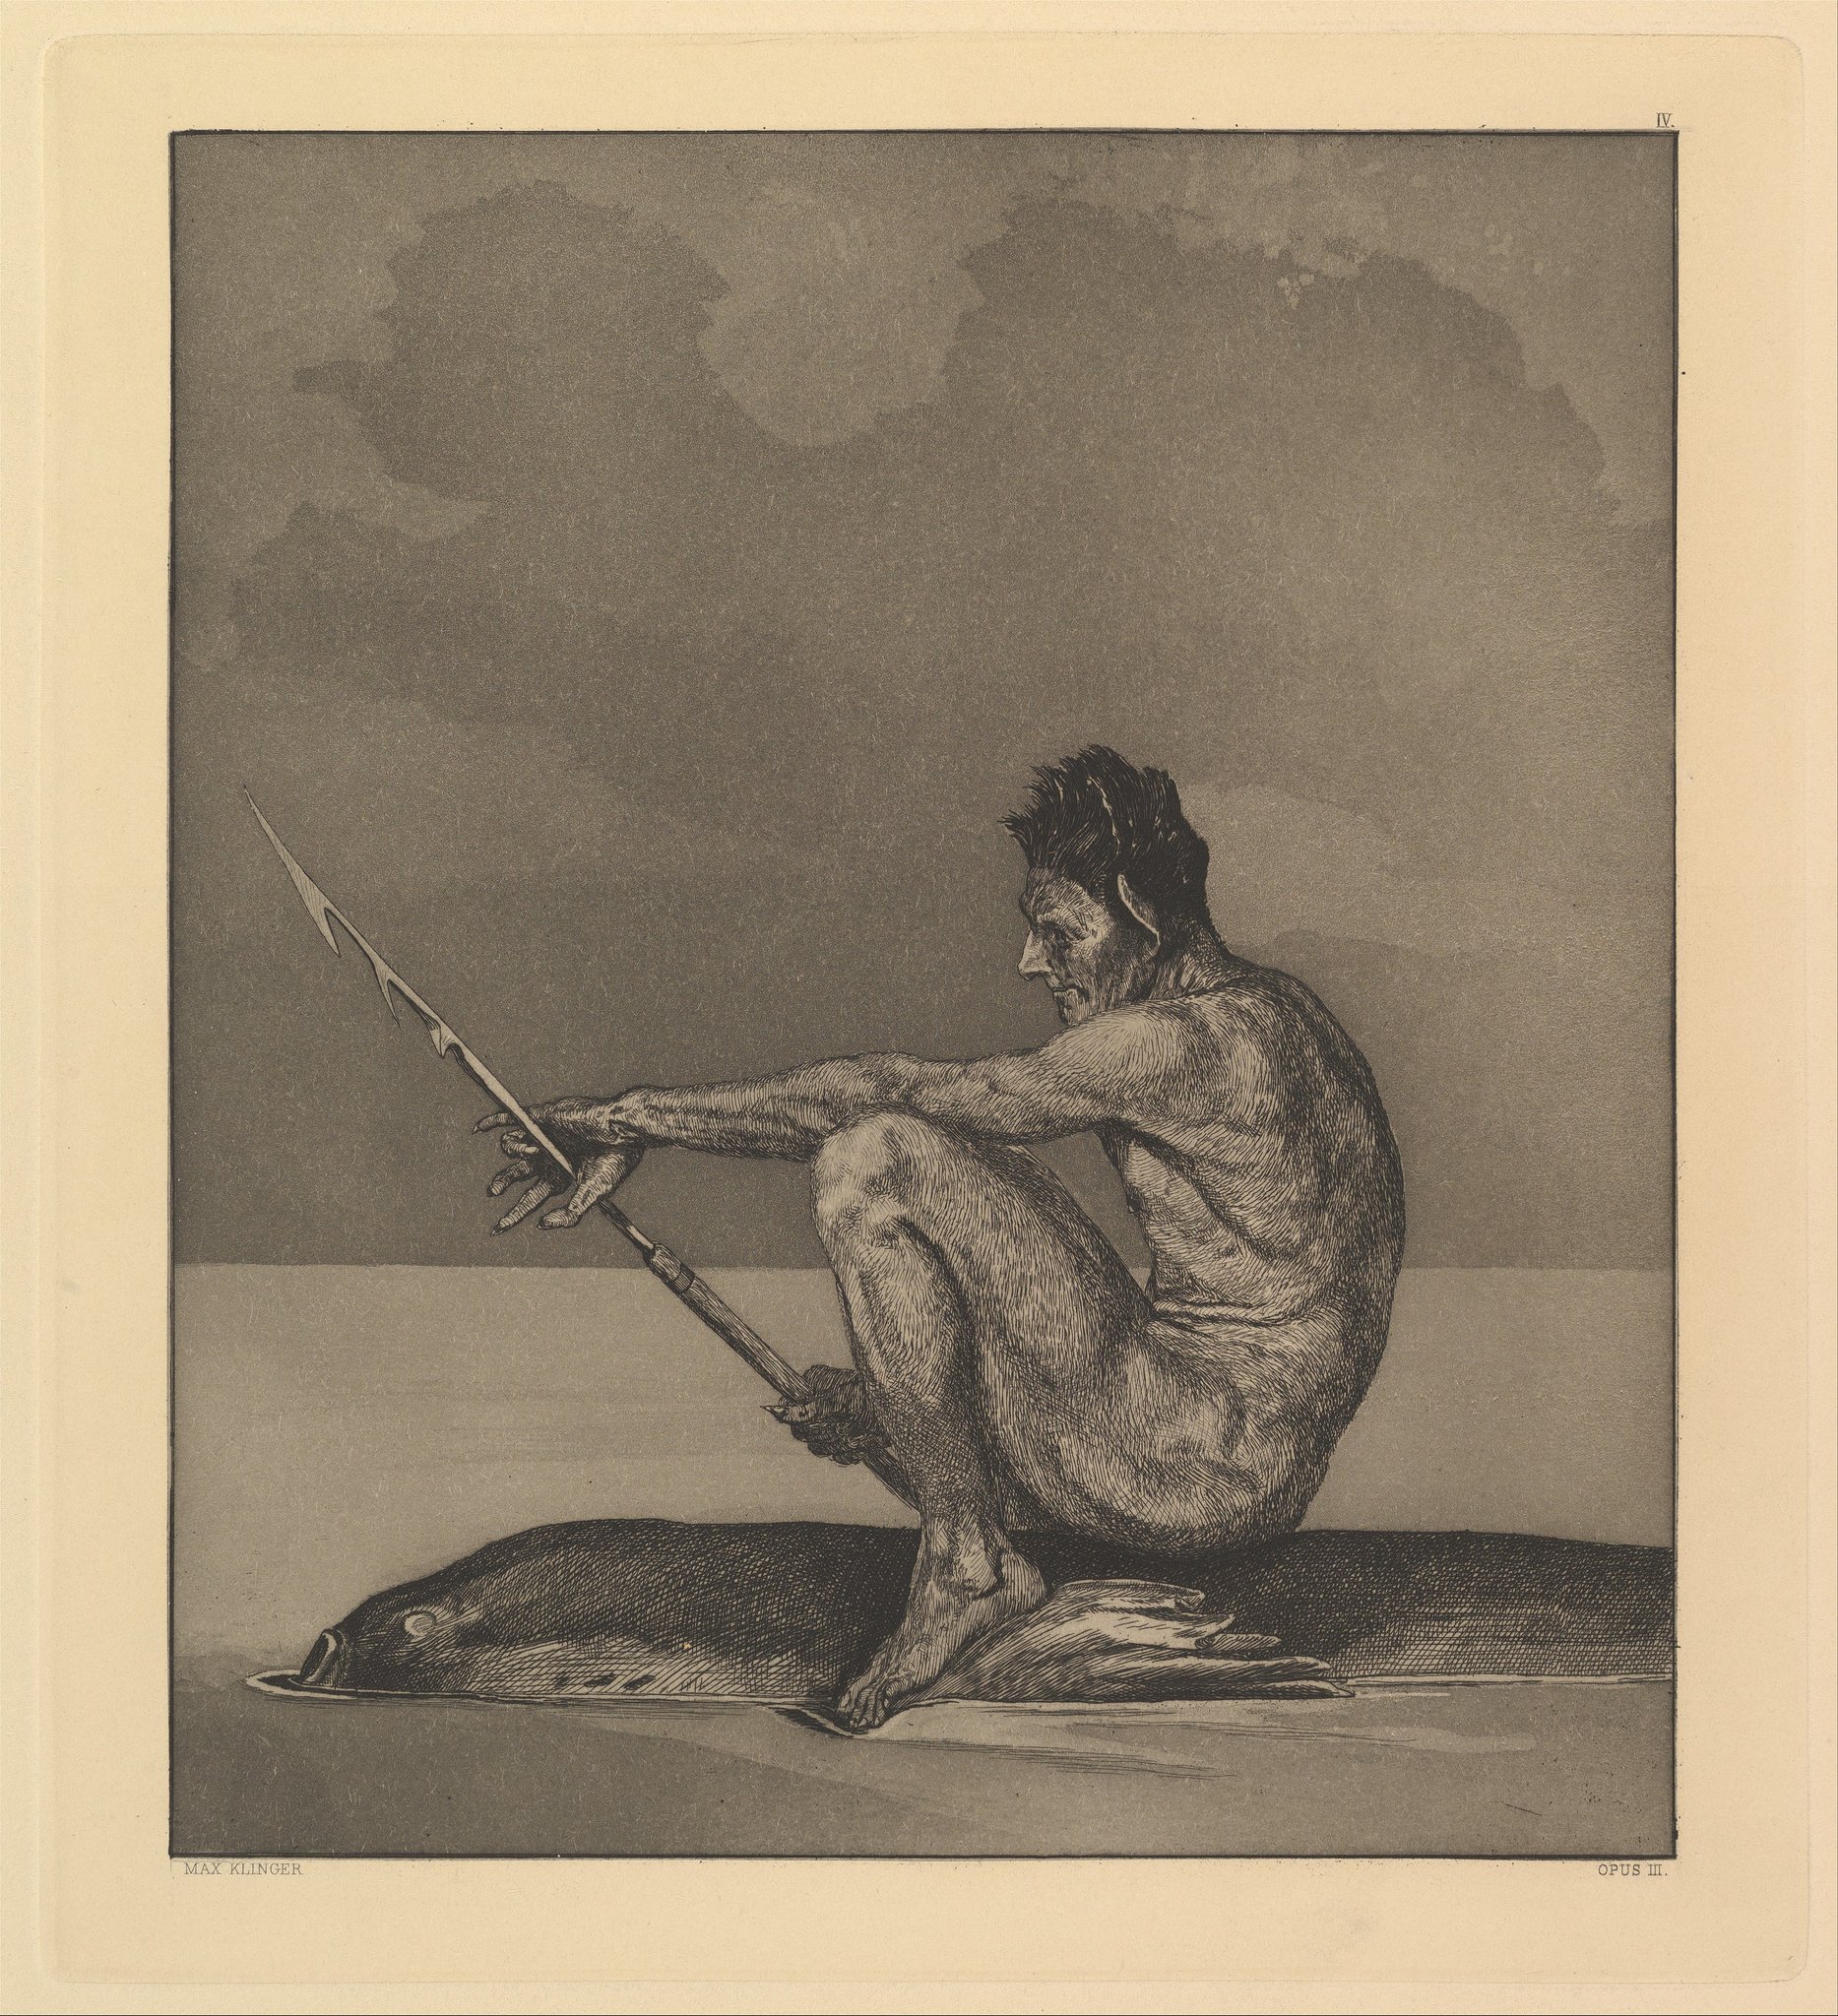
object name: print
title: Zweite Zukunft from Eva und die Zukunft (Rad.-Werk III)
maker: max klinger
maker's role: artist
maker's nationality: german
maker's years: 1857-1920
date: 1898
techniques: aquatint, etching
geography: germany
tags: male nudes,fish